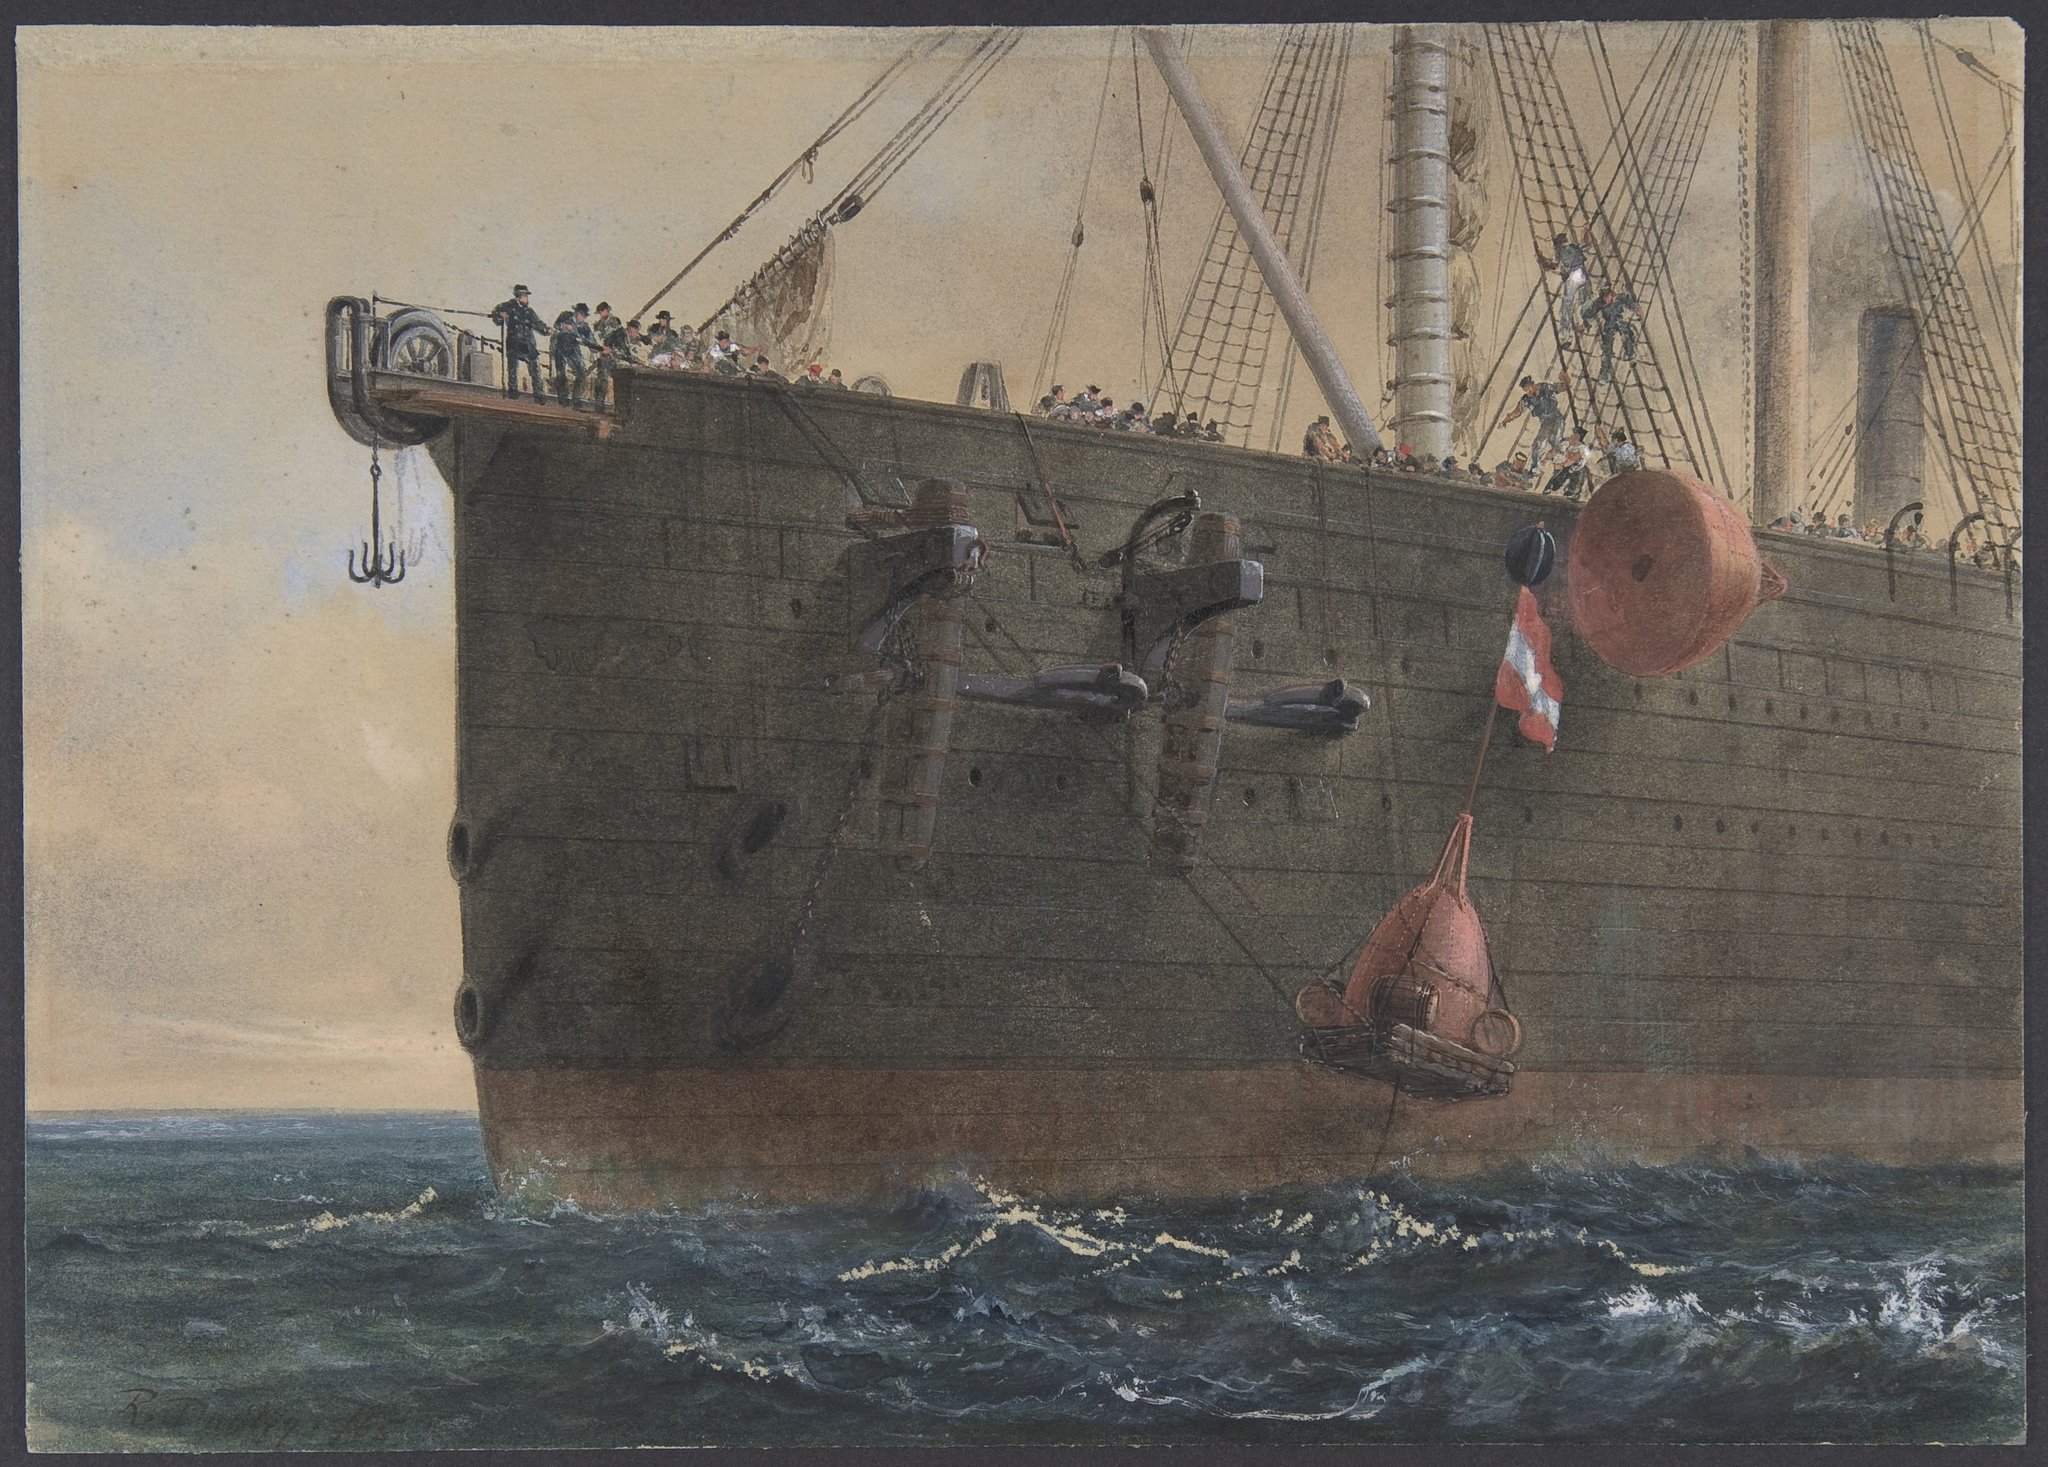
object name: drawing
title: In the Bows of the Great Eastern: The Cable Broken and Lost, Preparing to Grapple, August 2nd, 1865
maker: robert charles dudley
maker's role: artist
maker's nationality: british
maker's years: 1826-1909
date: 1865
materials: gouache, graphite, watercolor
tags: industry,ships,transatlantic cable